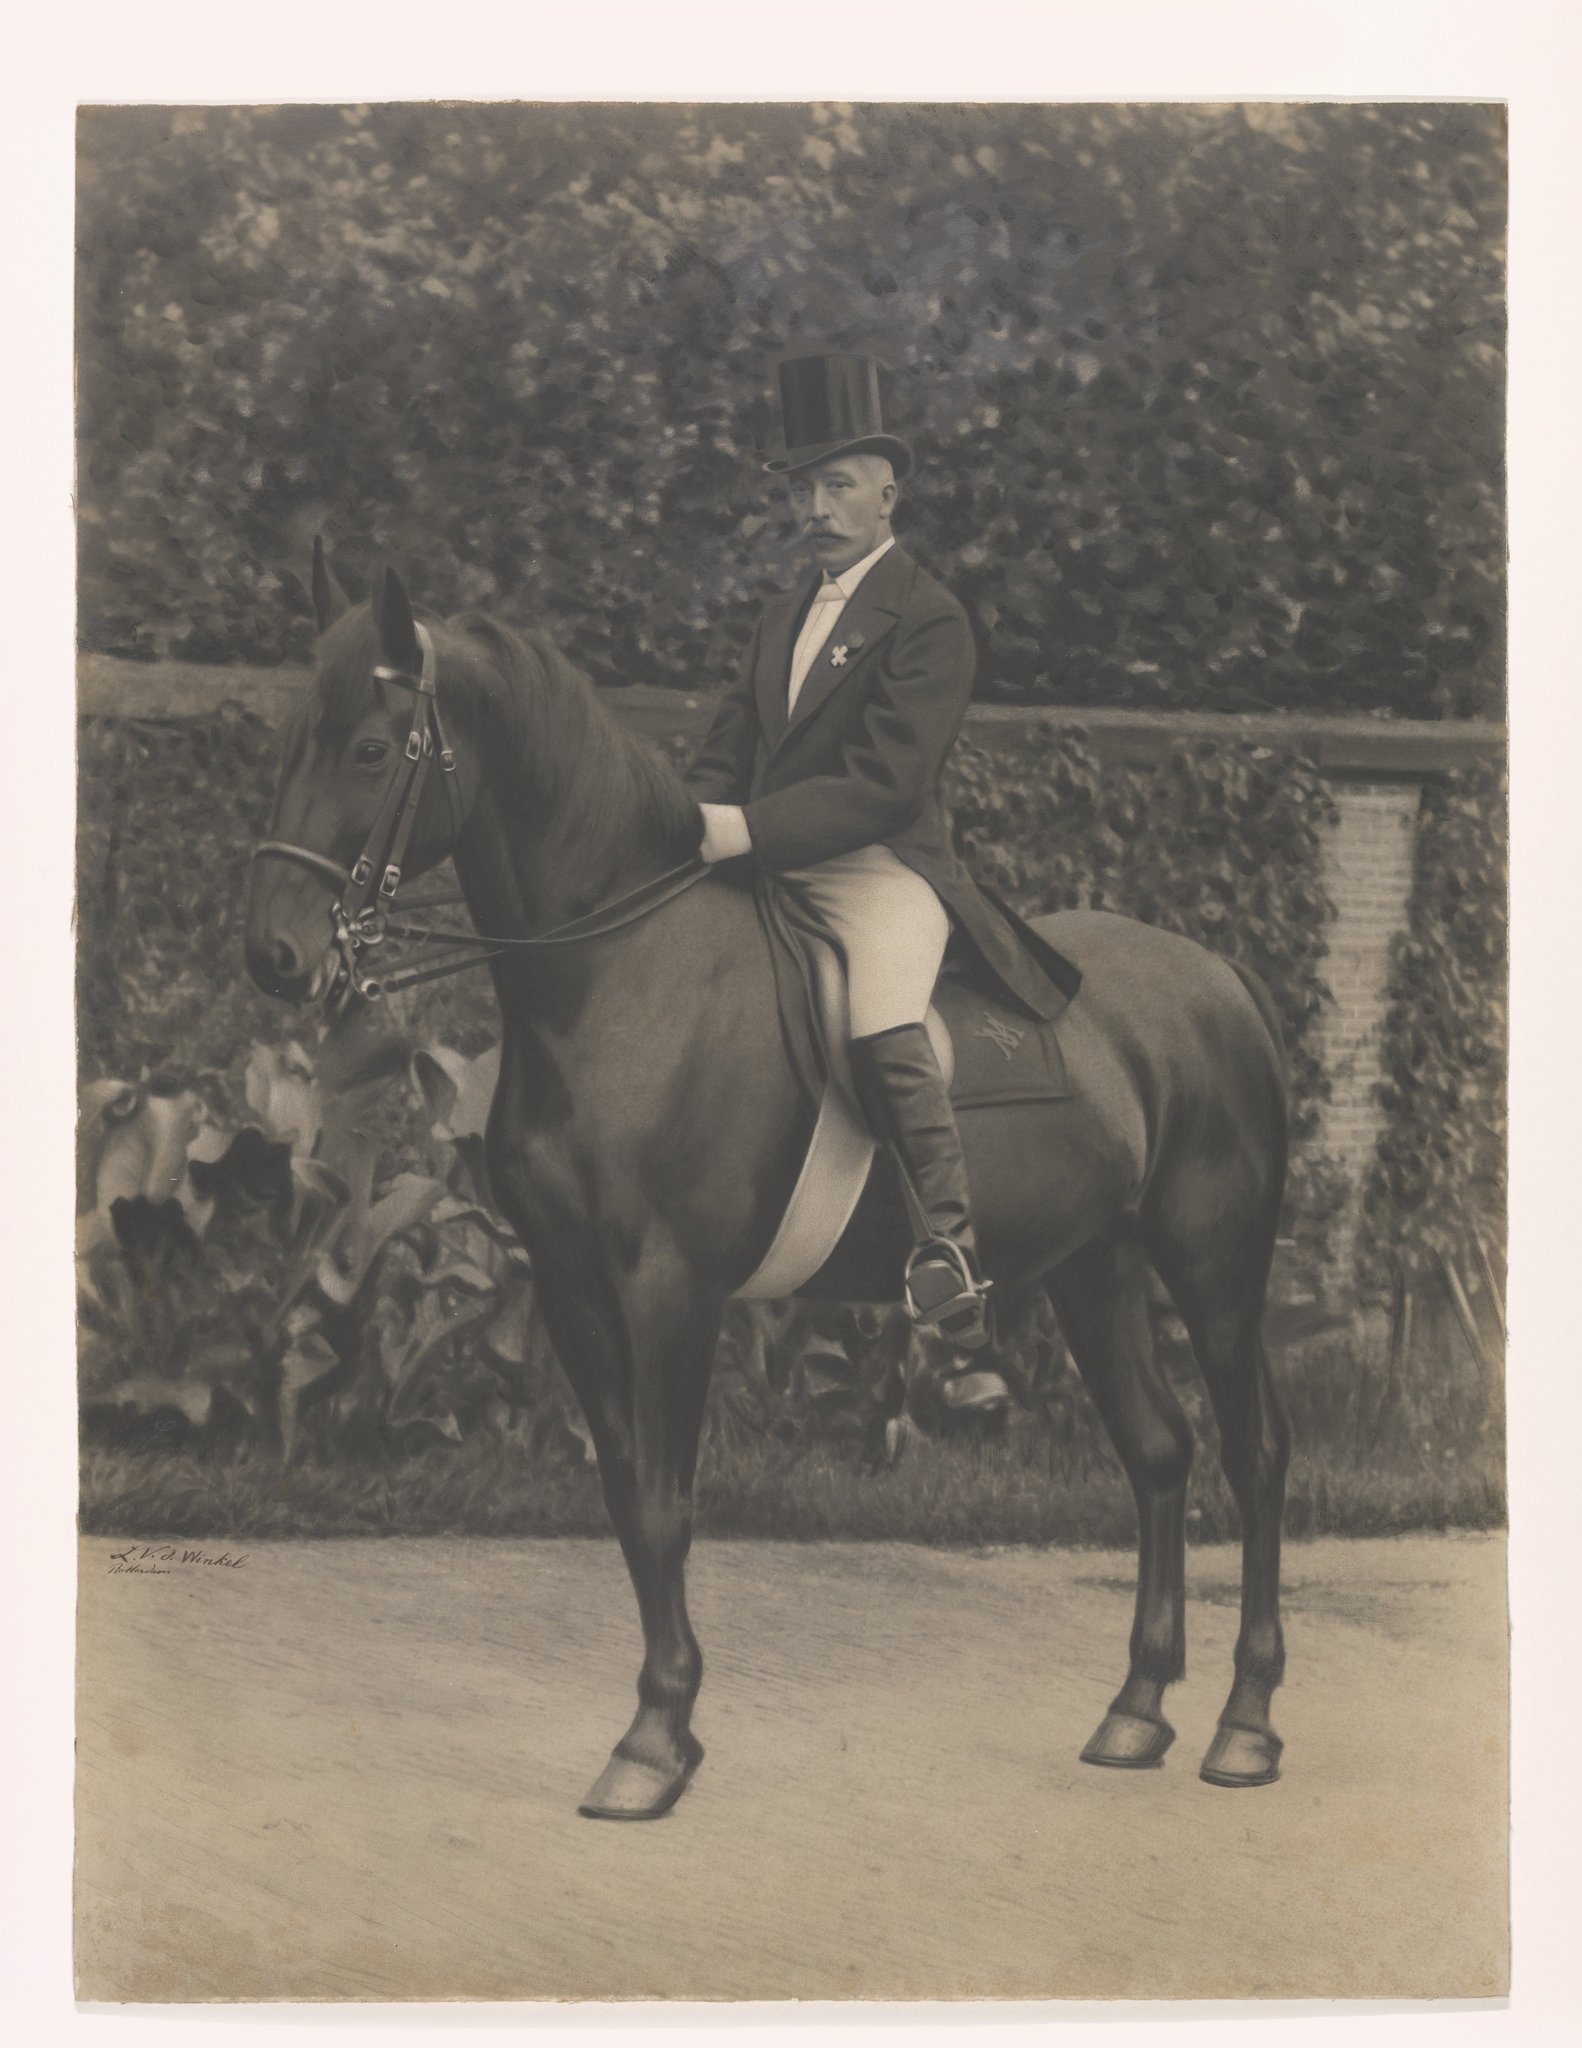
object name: photograph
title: Portret van een man (lid van de familie Van Heerdt) te paard (ruiterportret), Baarn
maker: lodewijk van de winkel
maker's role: fotograaf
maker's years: 1856-1919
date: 1900-1925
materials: cardboard, photographic support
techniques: gelatin silver print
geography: rotterdam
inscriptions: signature: ‘L. v.d. Winkel / Rotterdam’